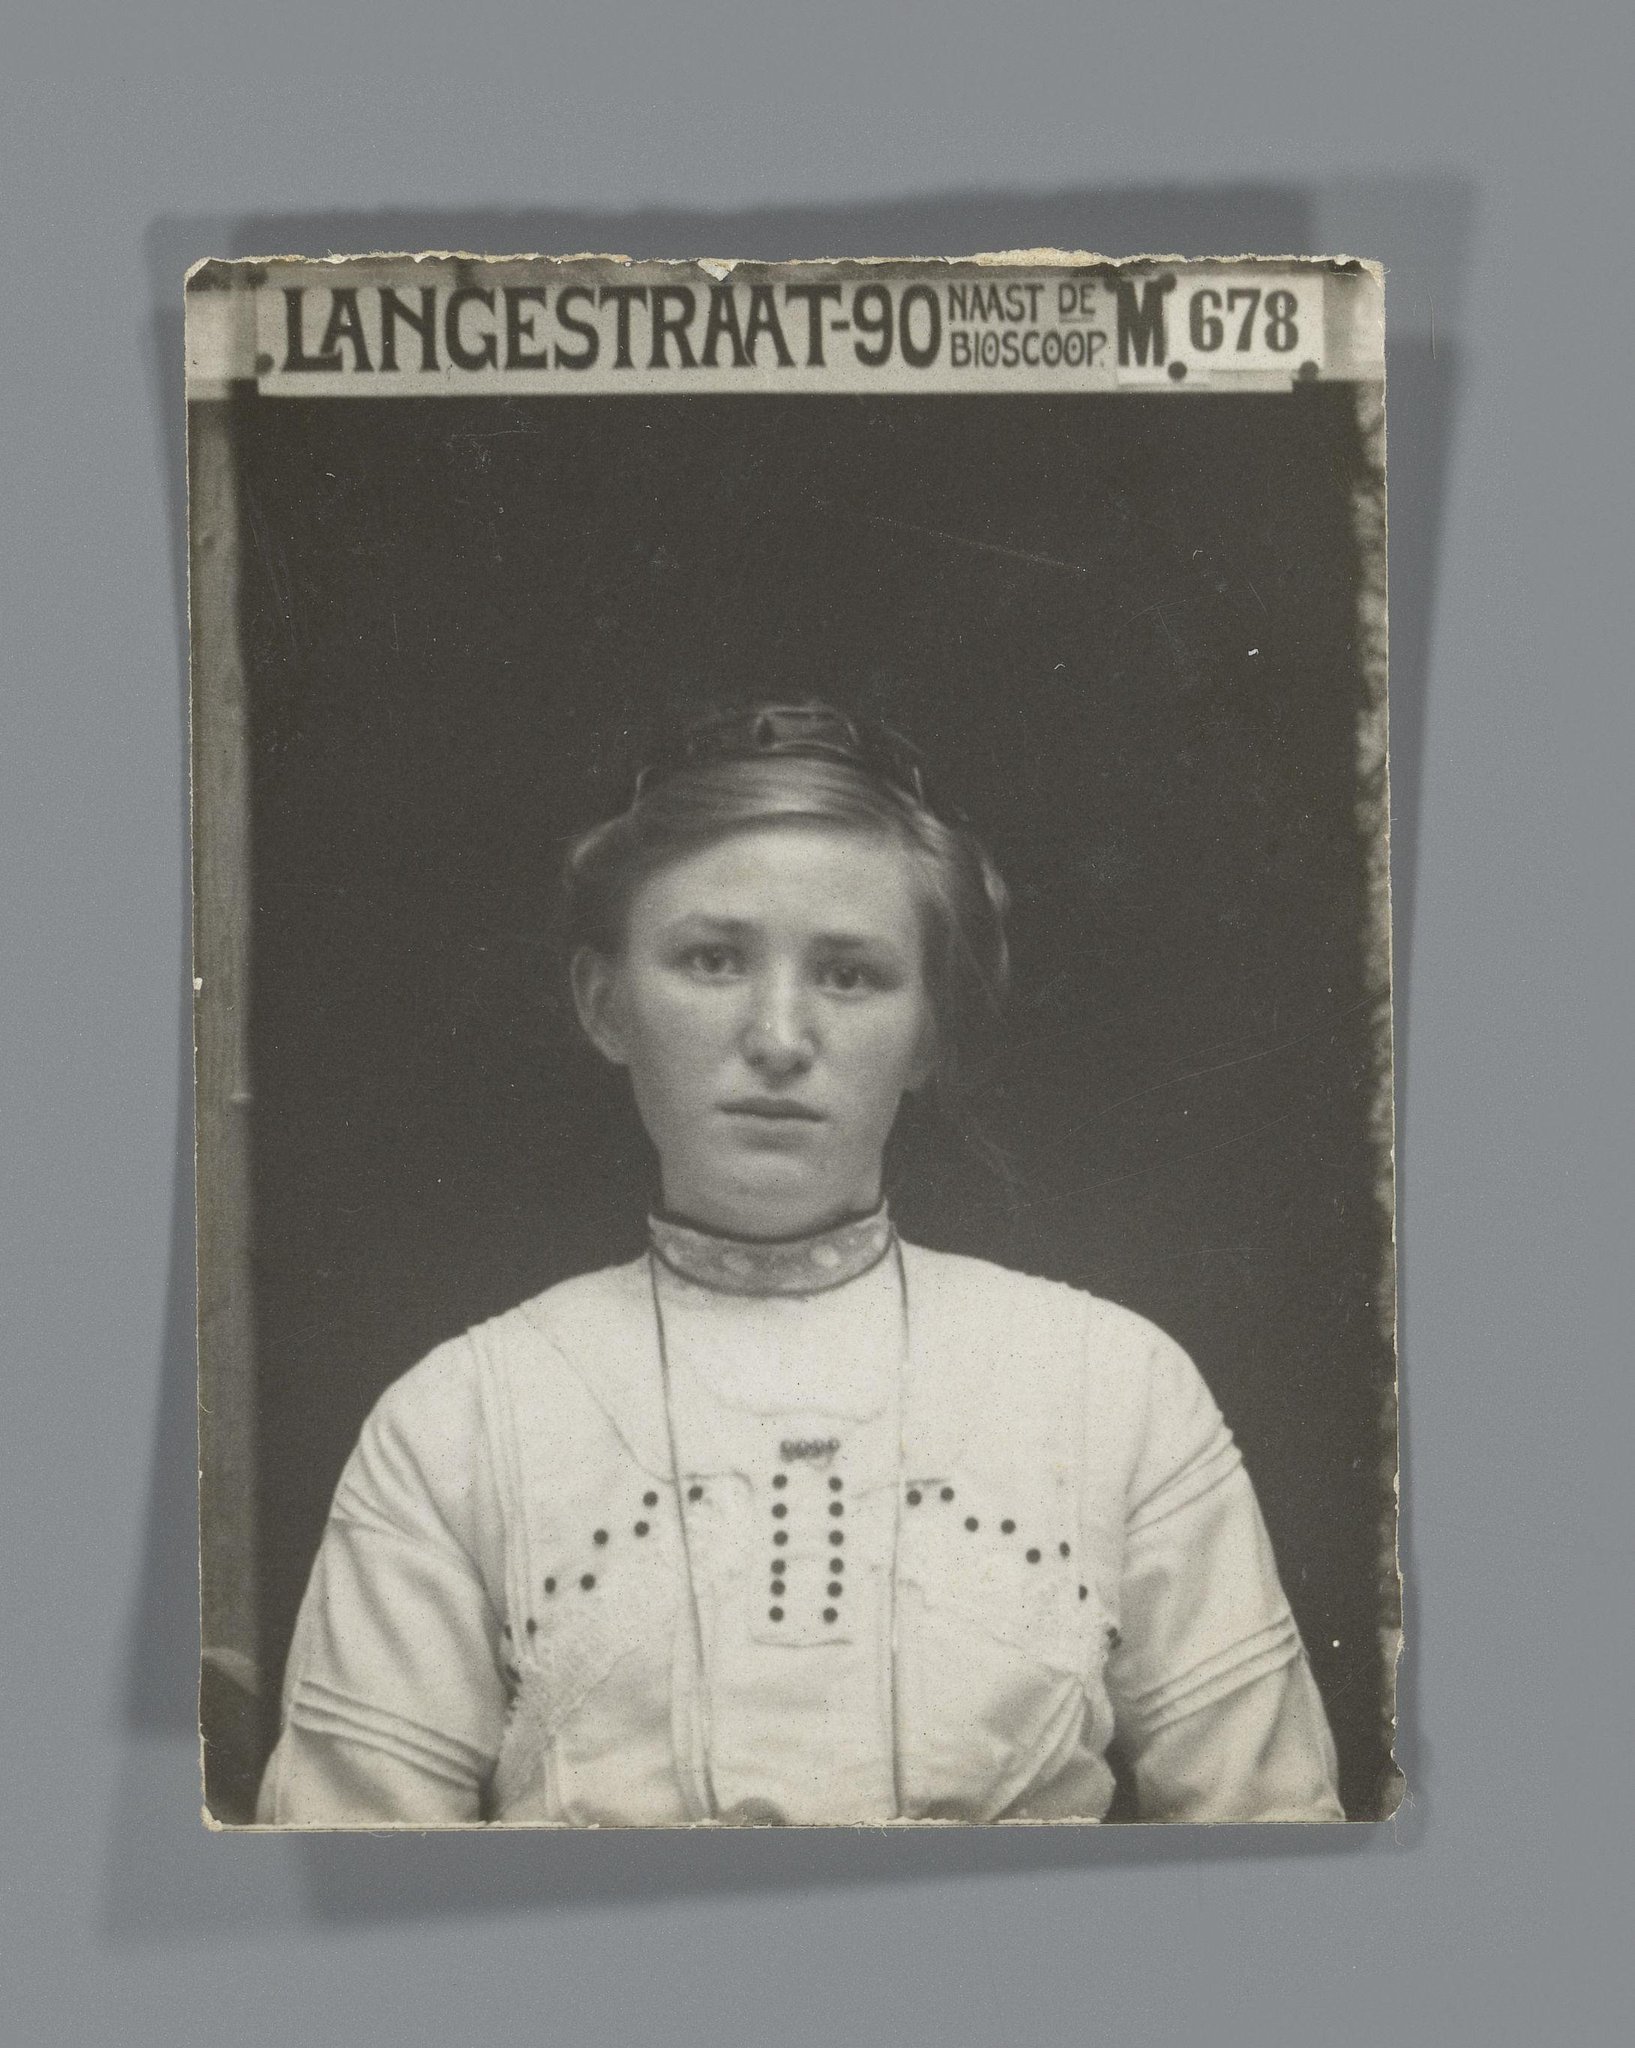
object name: snapshot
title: Rapid photographs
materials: photographic support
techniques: gelatin silver print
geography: alkmaar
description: Between 1912 and 1930, anyone could have their portrait taken at the many so-called rapid photography studios in the shopping streets of mainly (medium) large-size European cities. As if on an assembly line, the youngest clerk shot the photographs with a special camera and in artificial light and developed them. Later in the day, the customer collected a sheet with 12 portrait photos for 25 cents. This form of photographic mass production gave rise to a fascinating tableau of boys, girls, men and women not previously seen in photographs; candid and informal. There were at least 150 quick-photo studios, from Alkmaar to Zutphen. Many called themselves ‘American,’ mistakenly as it turns out because hardly any examples from that country have been found.